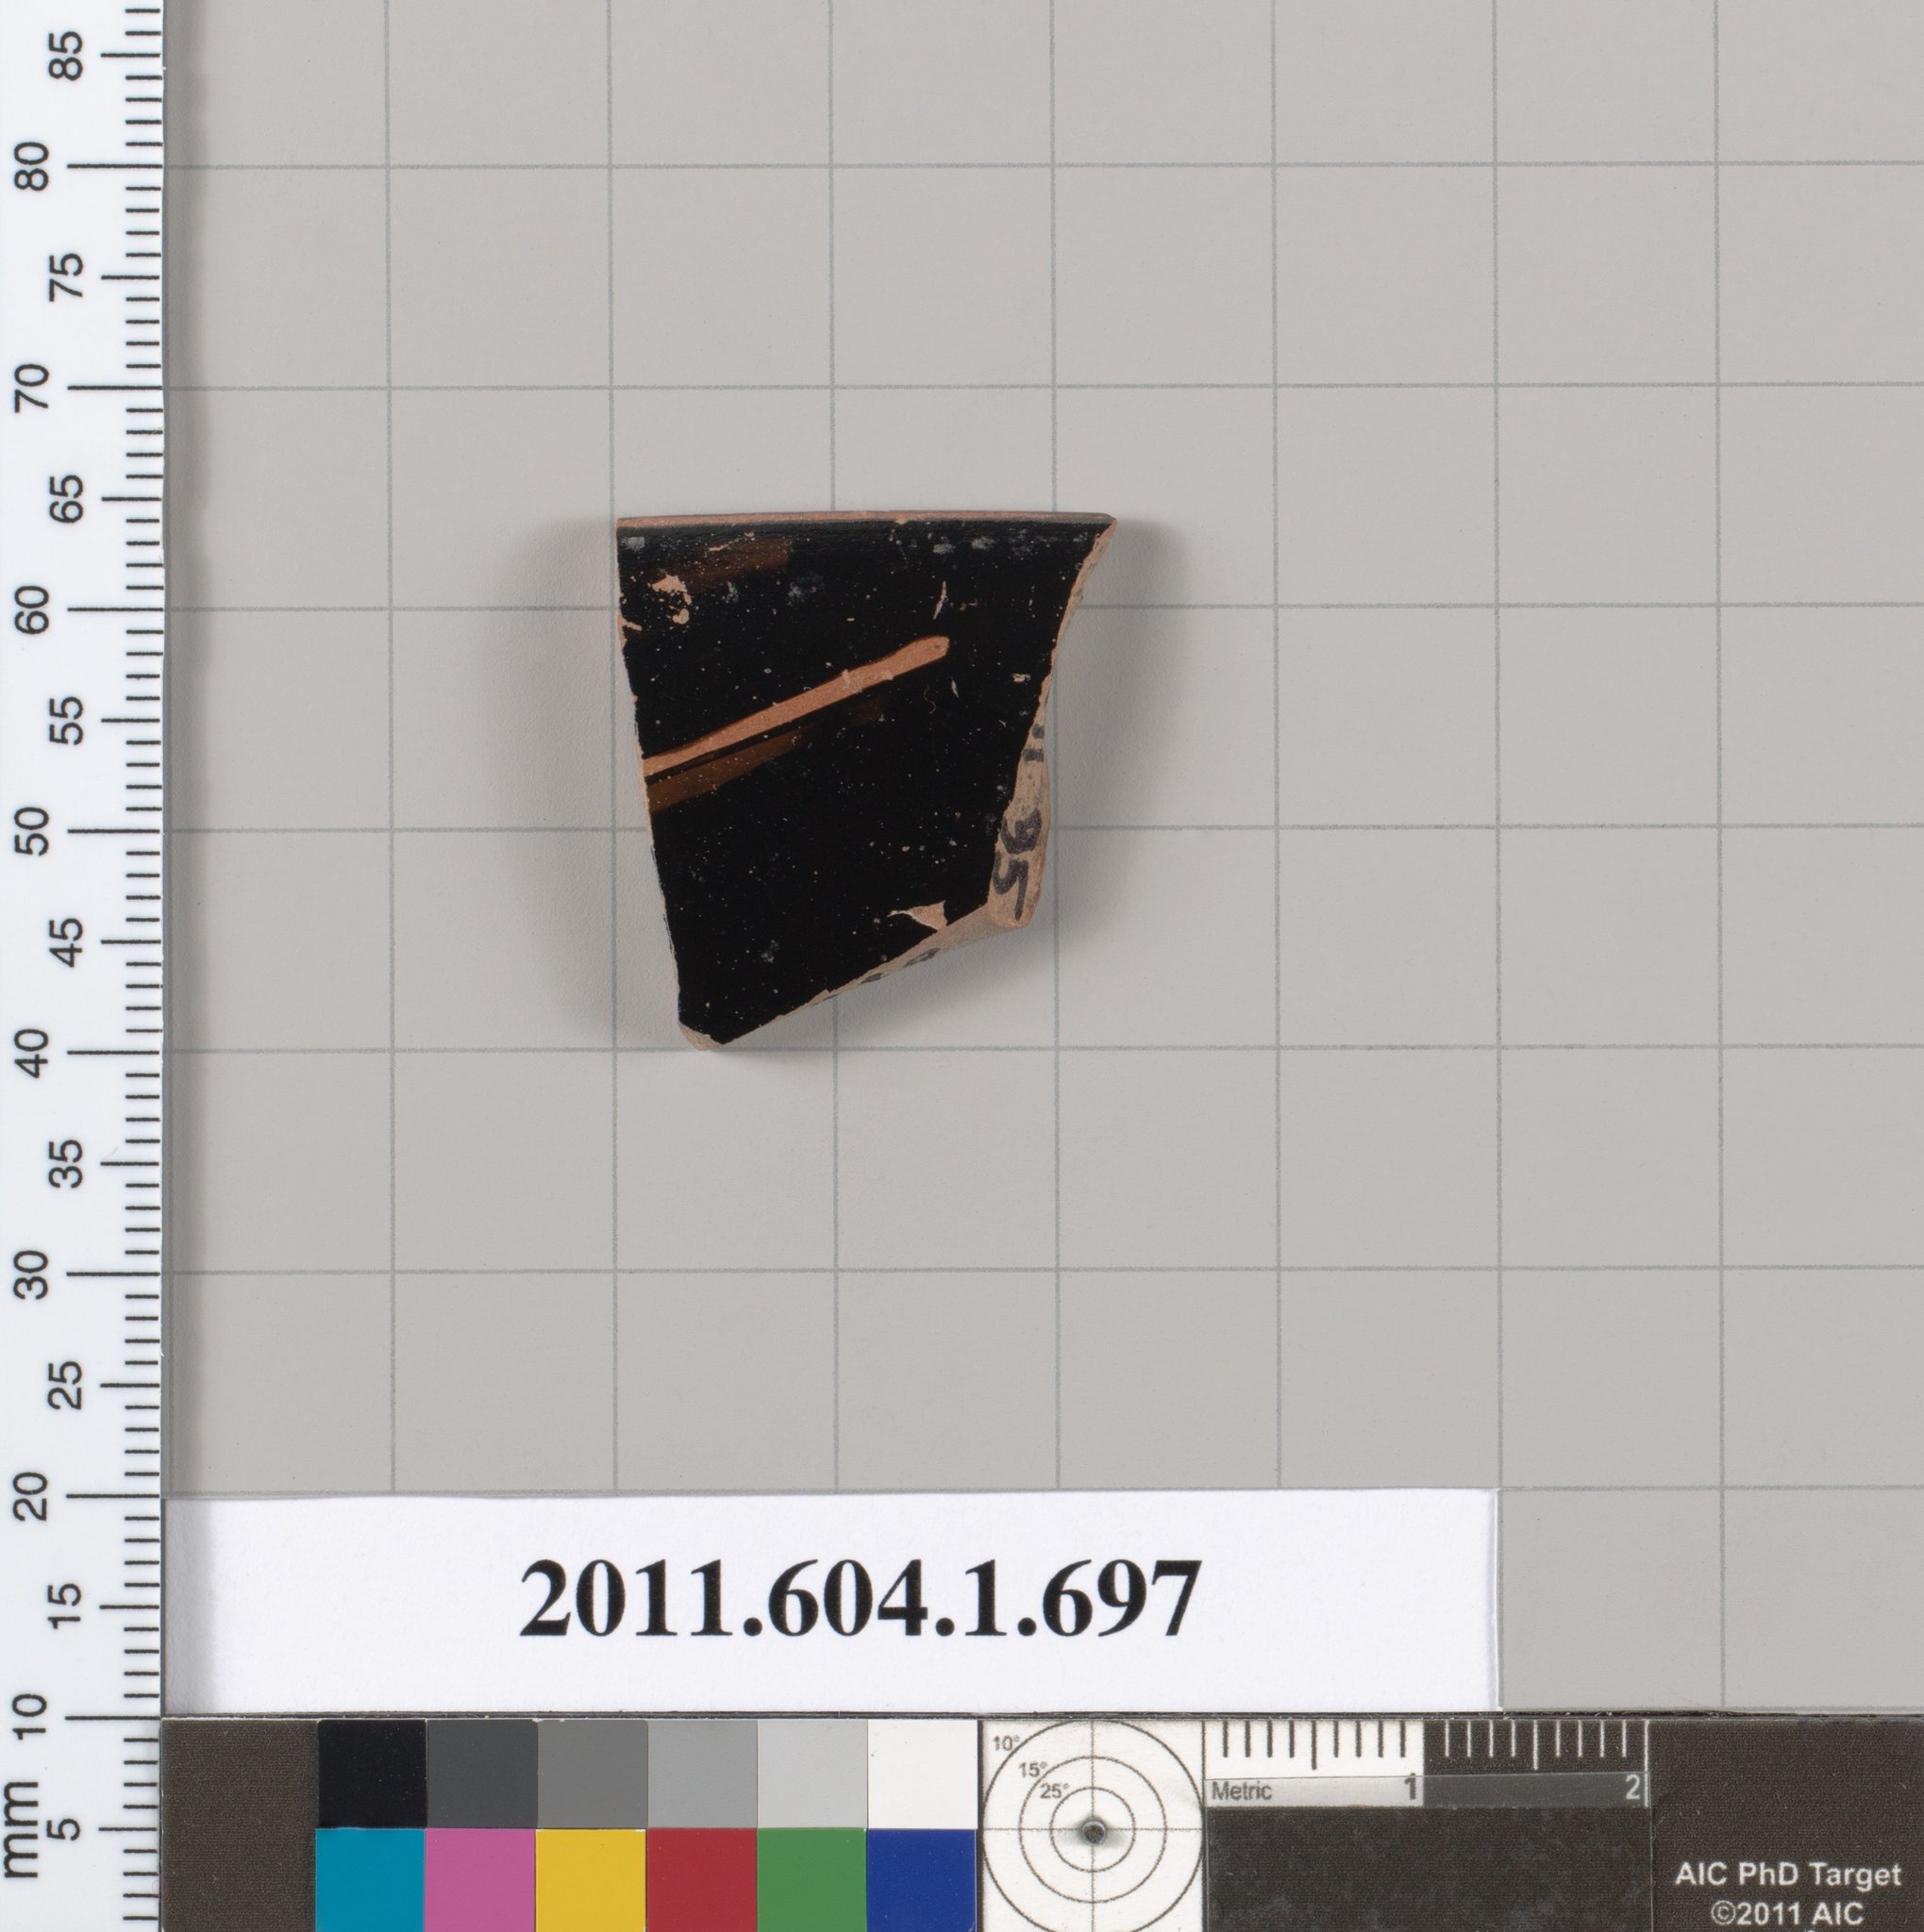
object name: kylix fragment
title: Terracotta rim fragment of a kylix (drinking cup)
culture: greek, attic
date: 475-451 BCE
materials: terracotta